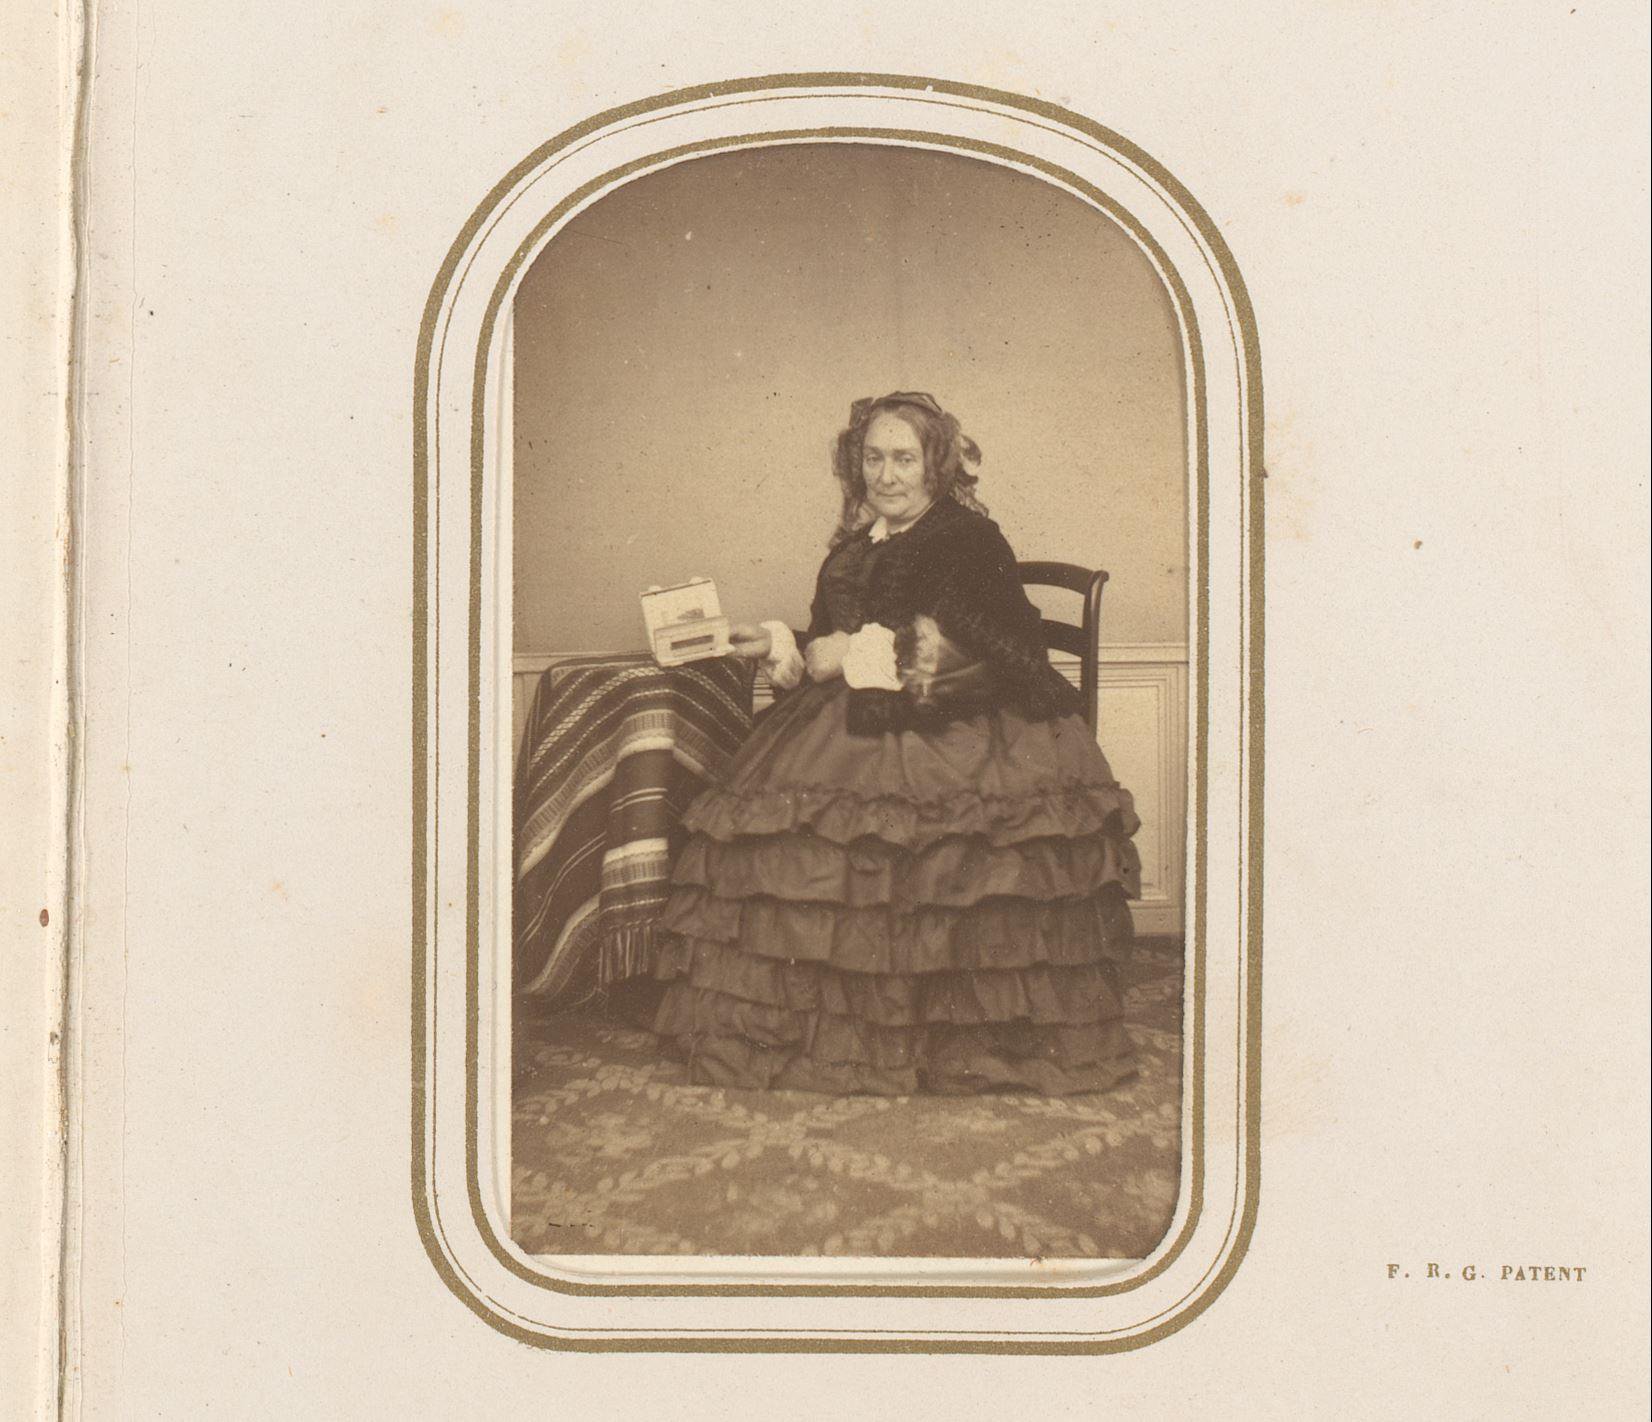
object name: carte de visite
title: Portret van een zittende vrouw met een boek in hand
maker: Anonymous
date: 1860-1890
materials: cardboard, photographic support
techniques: albumen print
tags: sitting figure - aa - female human figure, historical persons, book